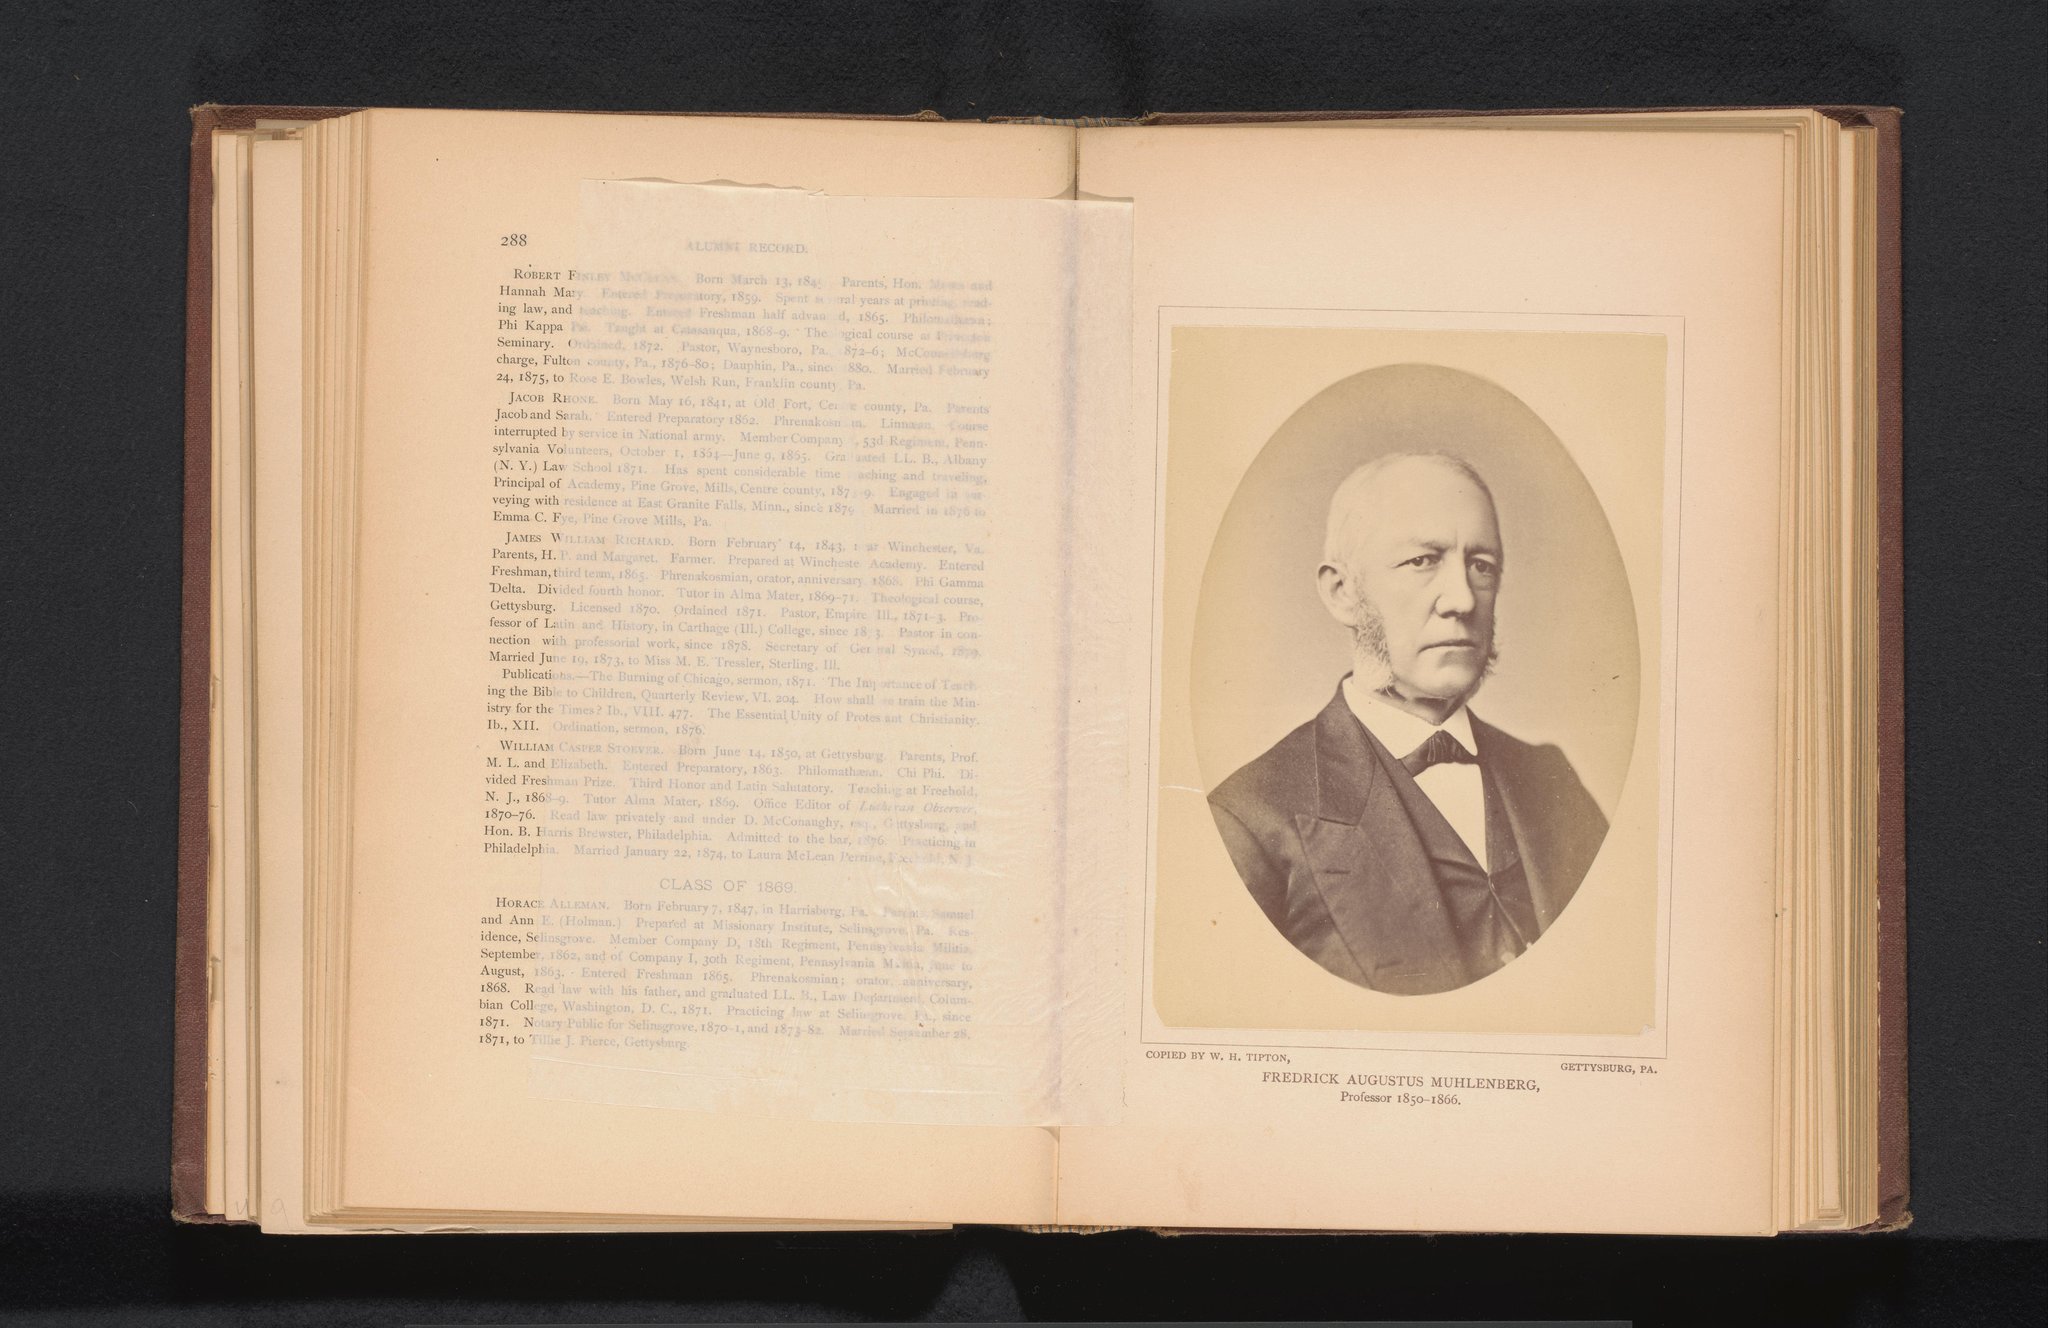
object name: photograph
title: Fredrick Augustus Muhlenberg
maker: william h. tipton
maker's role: fotograaf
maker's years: 1850-1920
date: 1877-1882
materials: photographic support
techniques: albumen print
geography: gettysburg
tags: professor